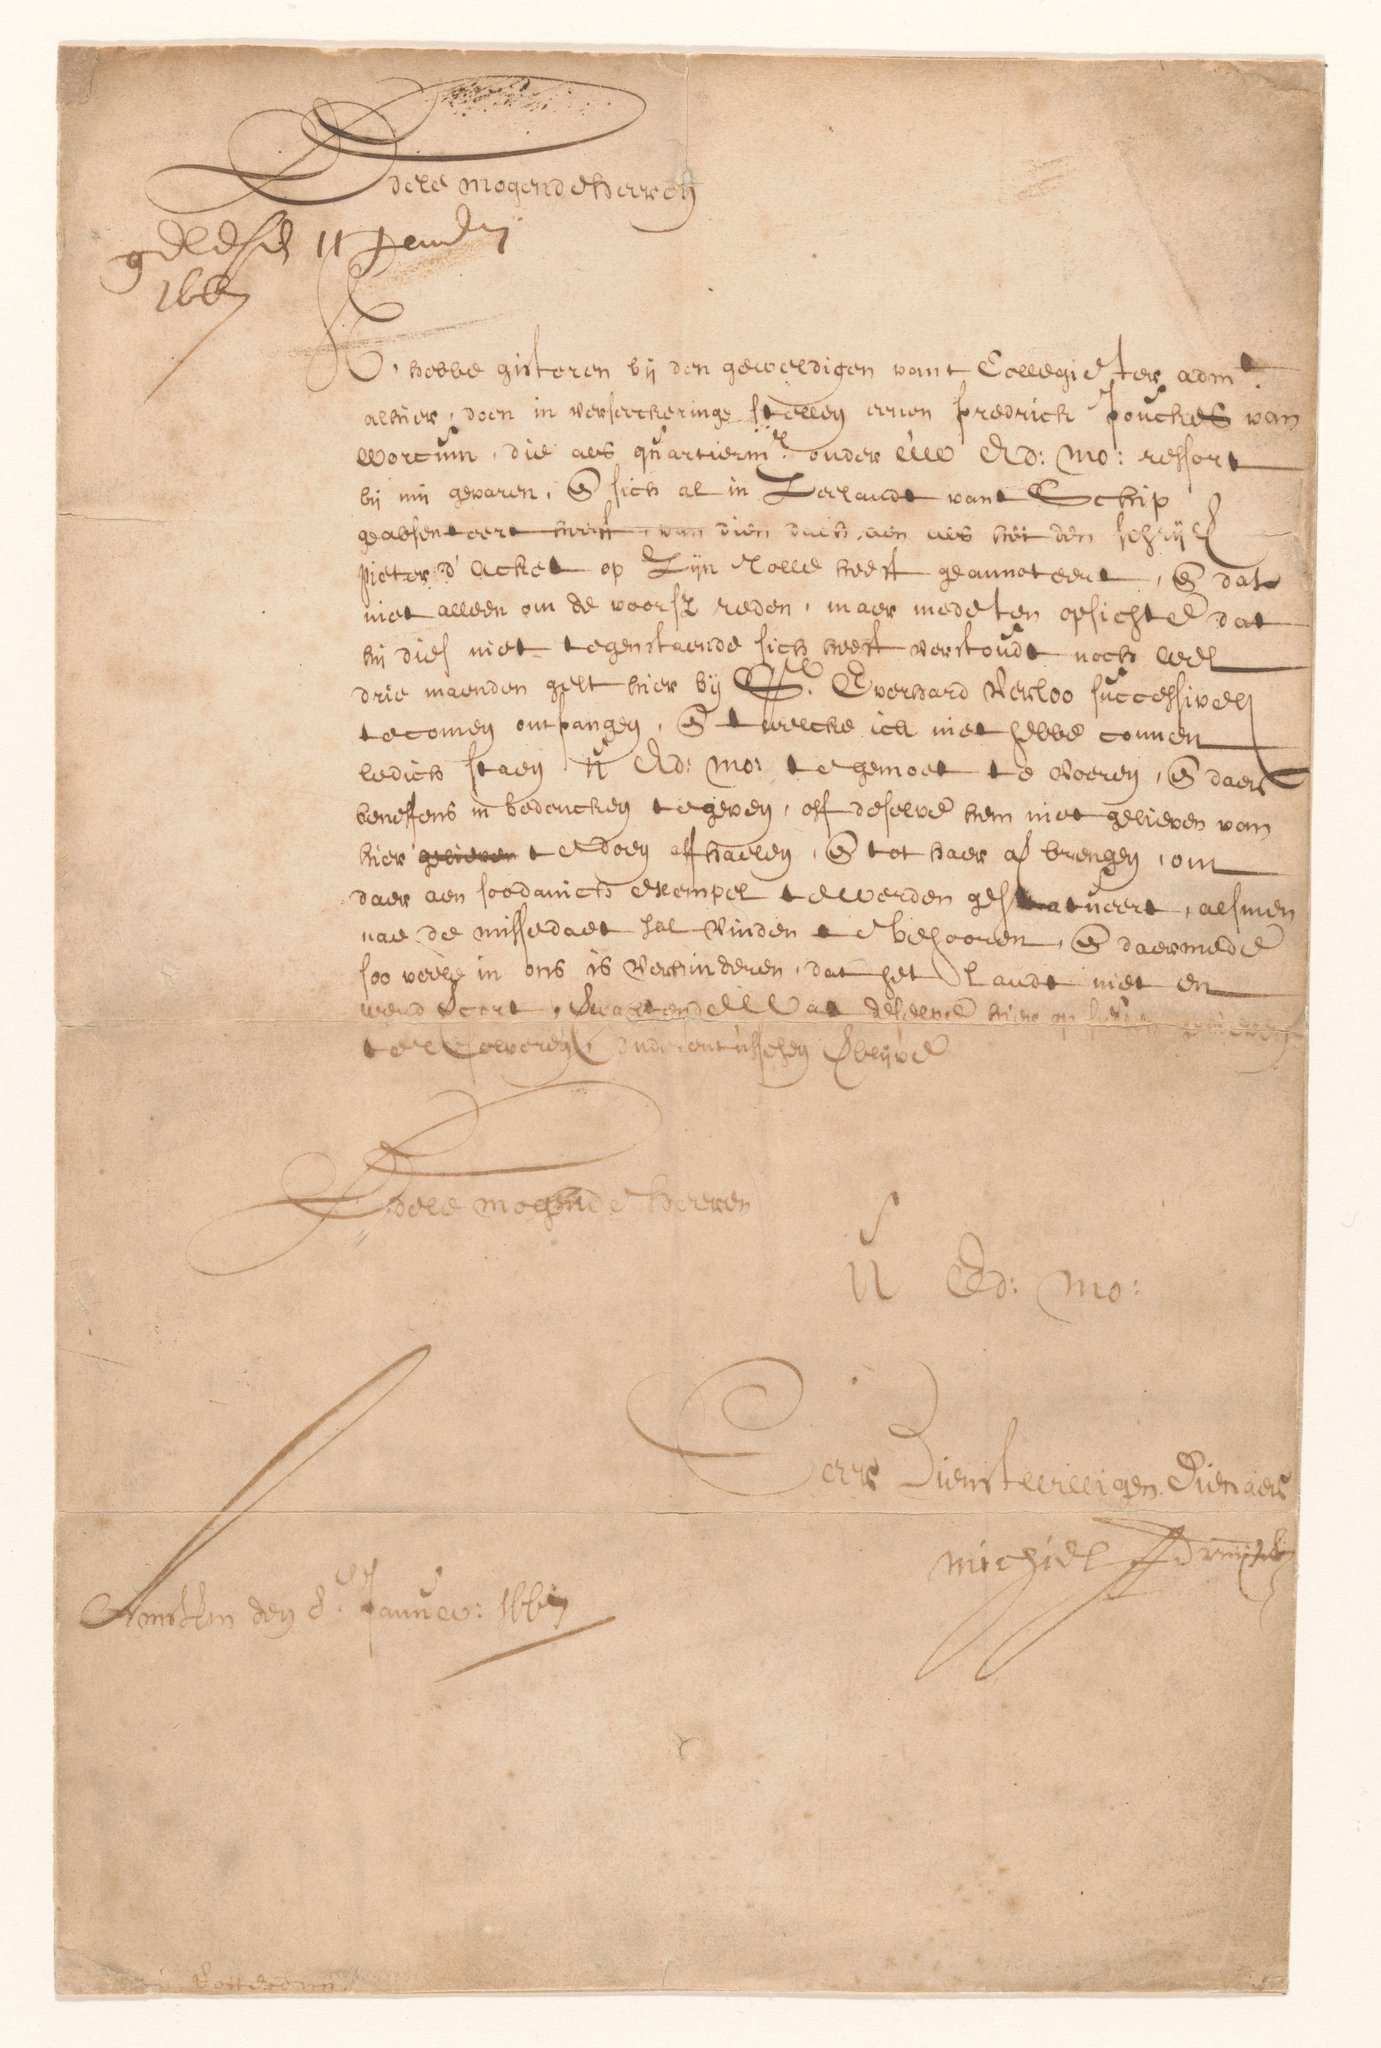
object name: letter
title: Brief van Michiel Adriaenszoon de Ruyter 8 januari 1667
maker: michiel adriaenszoon de ruyter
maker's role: admiraal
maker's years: 1607-1676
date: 1667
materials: ink, paper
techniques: pen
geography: amsterdam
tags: flushing, michiel adriaenszoon de ruyter, rotterdam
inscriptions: signature: ‘michiel Ad ruijter’, date: ‘de 8e. Jann : 1667’, inscription: ‘Edele mogende heeren....’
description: Handgeschreven brief van Michiel Adriaenszoon de Ruyter van 8 januari 1667 gericht aan de heren van de admiraliteit van Rotterdam betreffende de arrestatie van een kwartiermeester. Aan één kant beschreven.